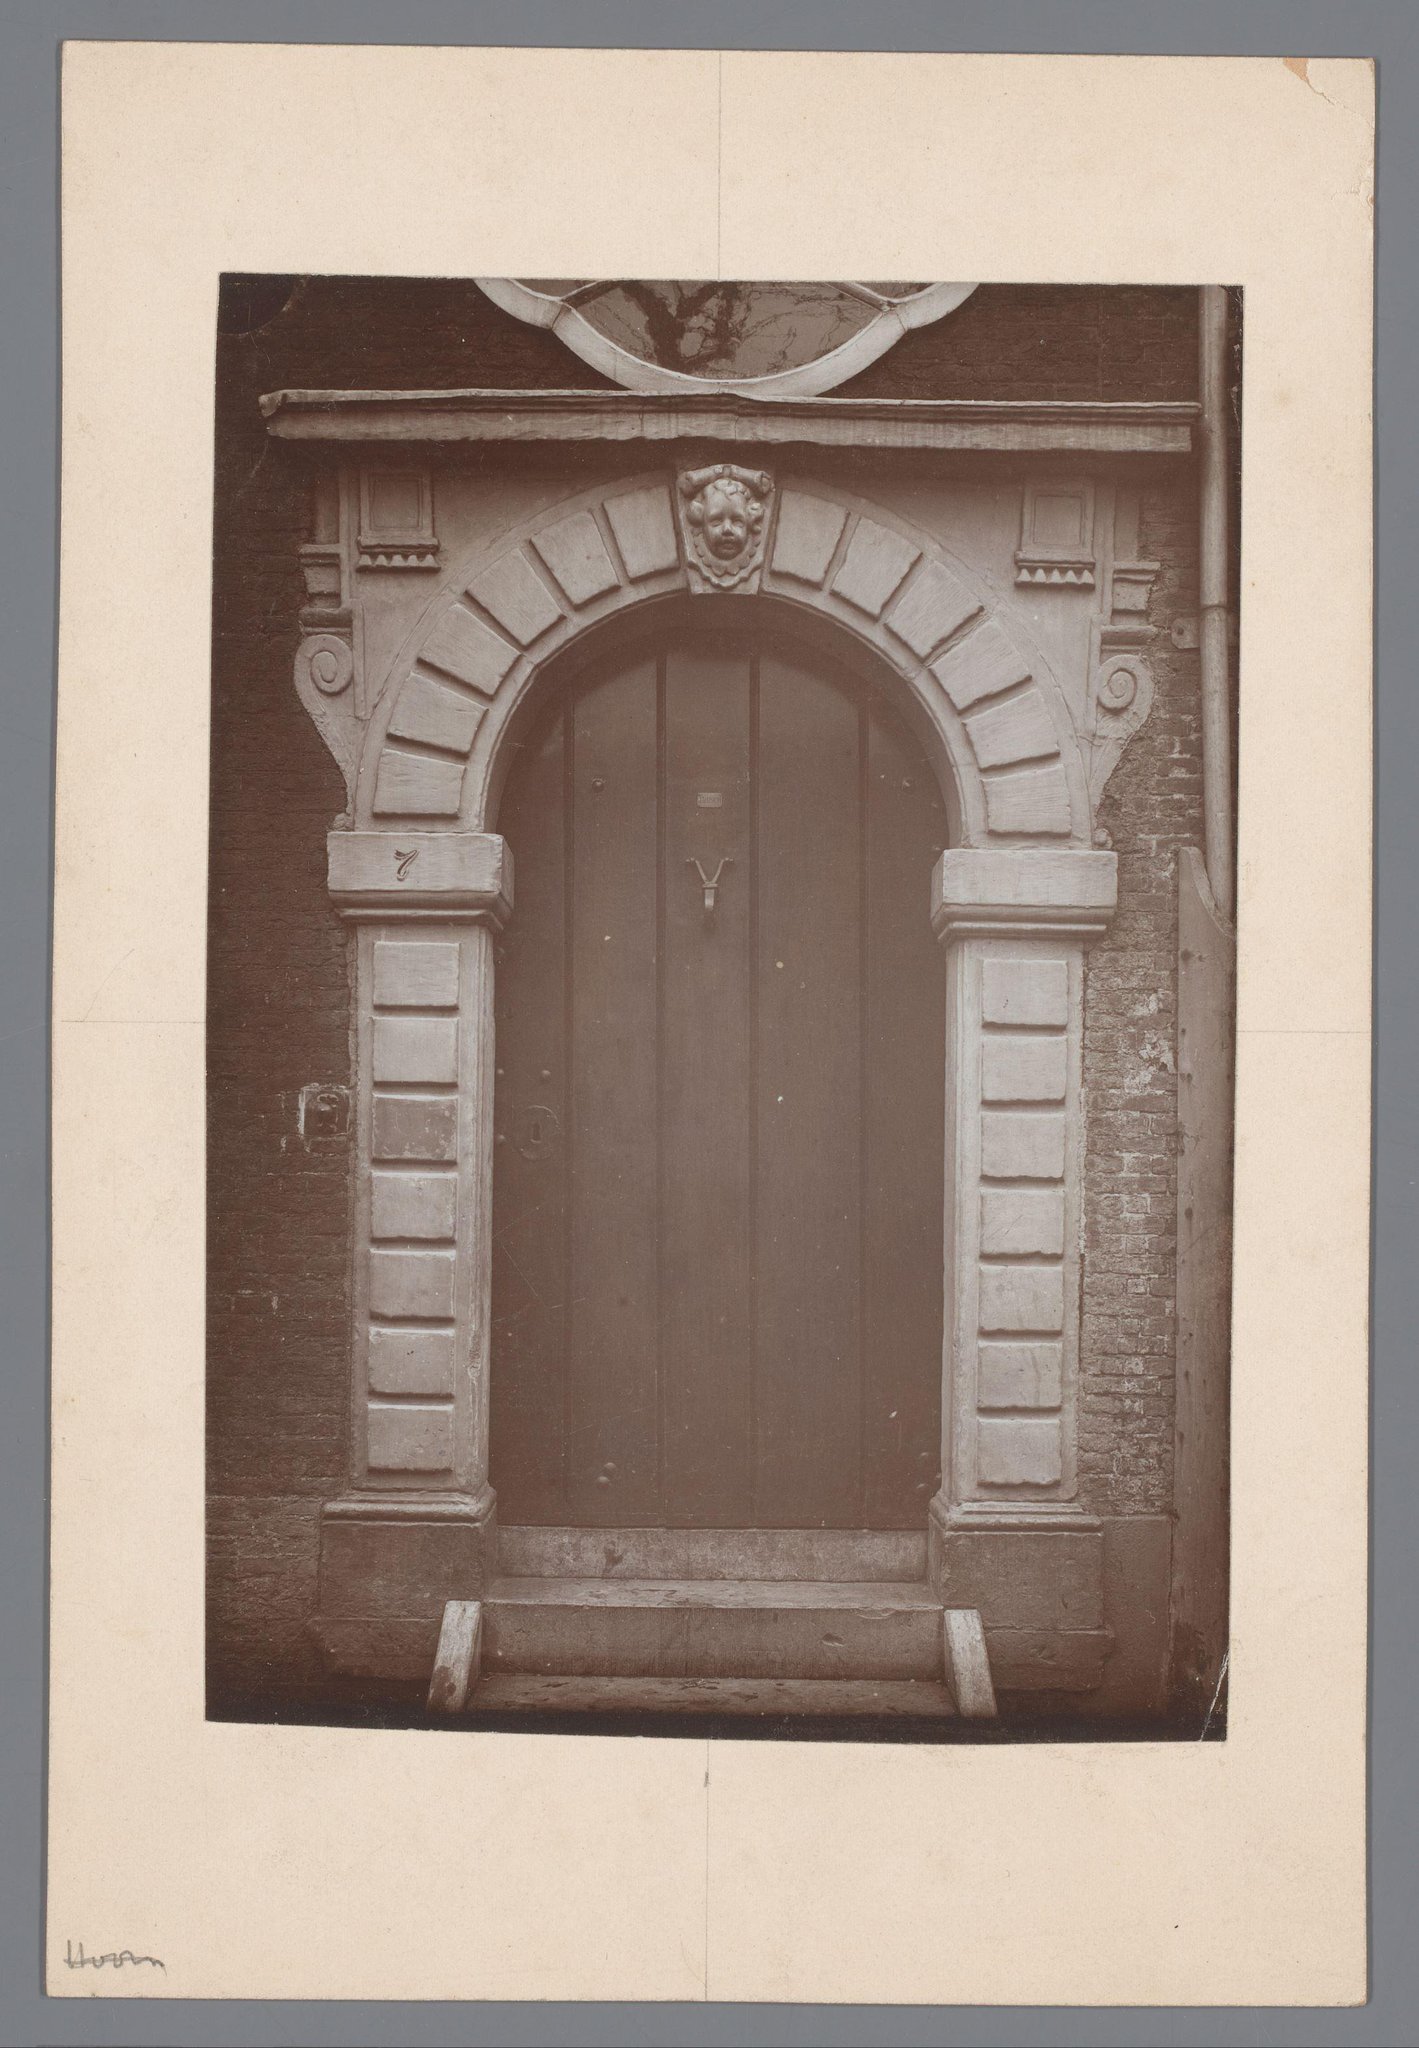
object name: photograph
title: Voordeur naar de woning van J. Busch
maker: Anonymous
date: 1880-1910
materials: paper, cardboard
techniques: collodion silver print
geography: netherlands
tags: gate, entrance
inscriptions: inscription: ‘'s Gravenhage, Hl. Geesthofje, Pav. gracht’